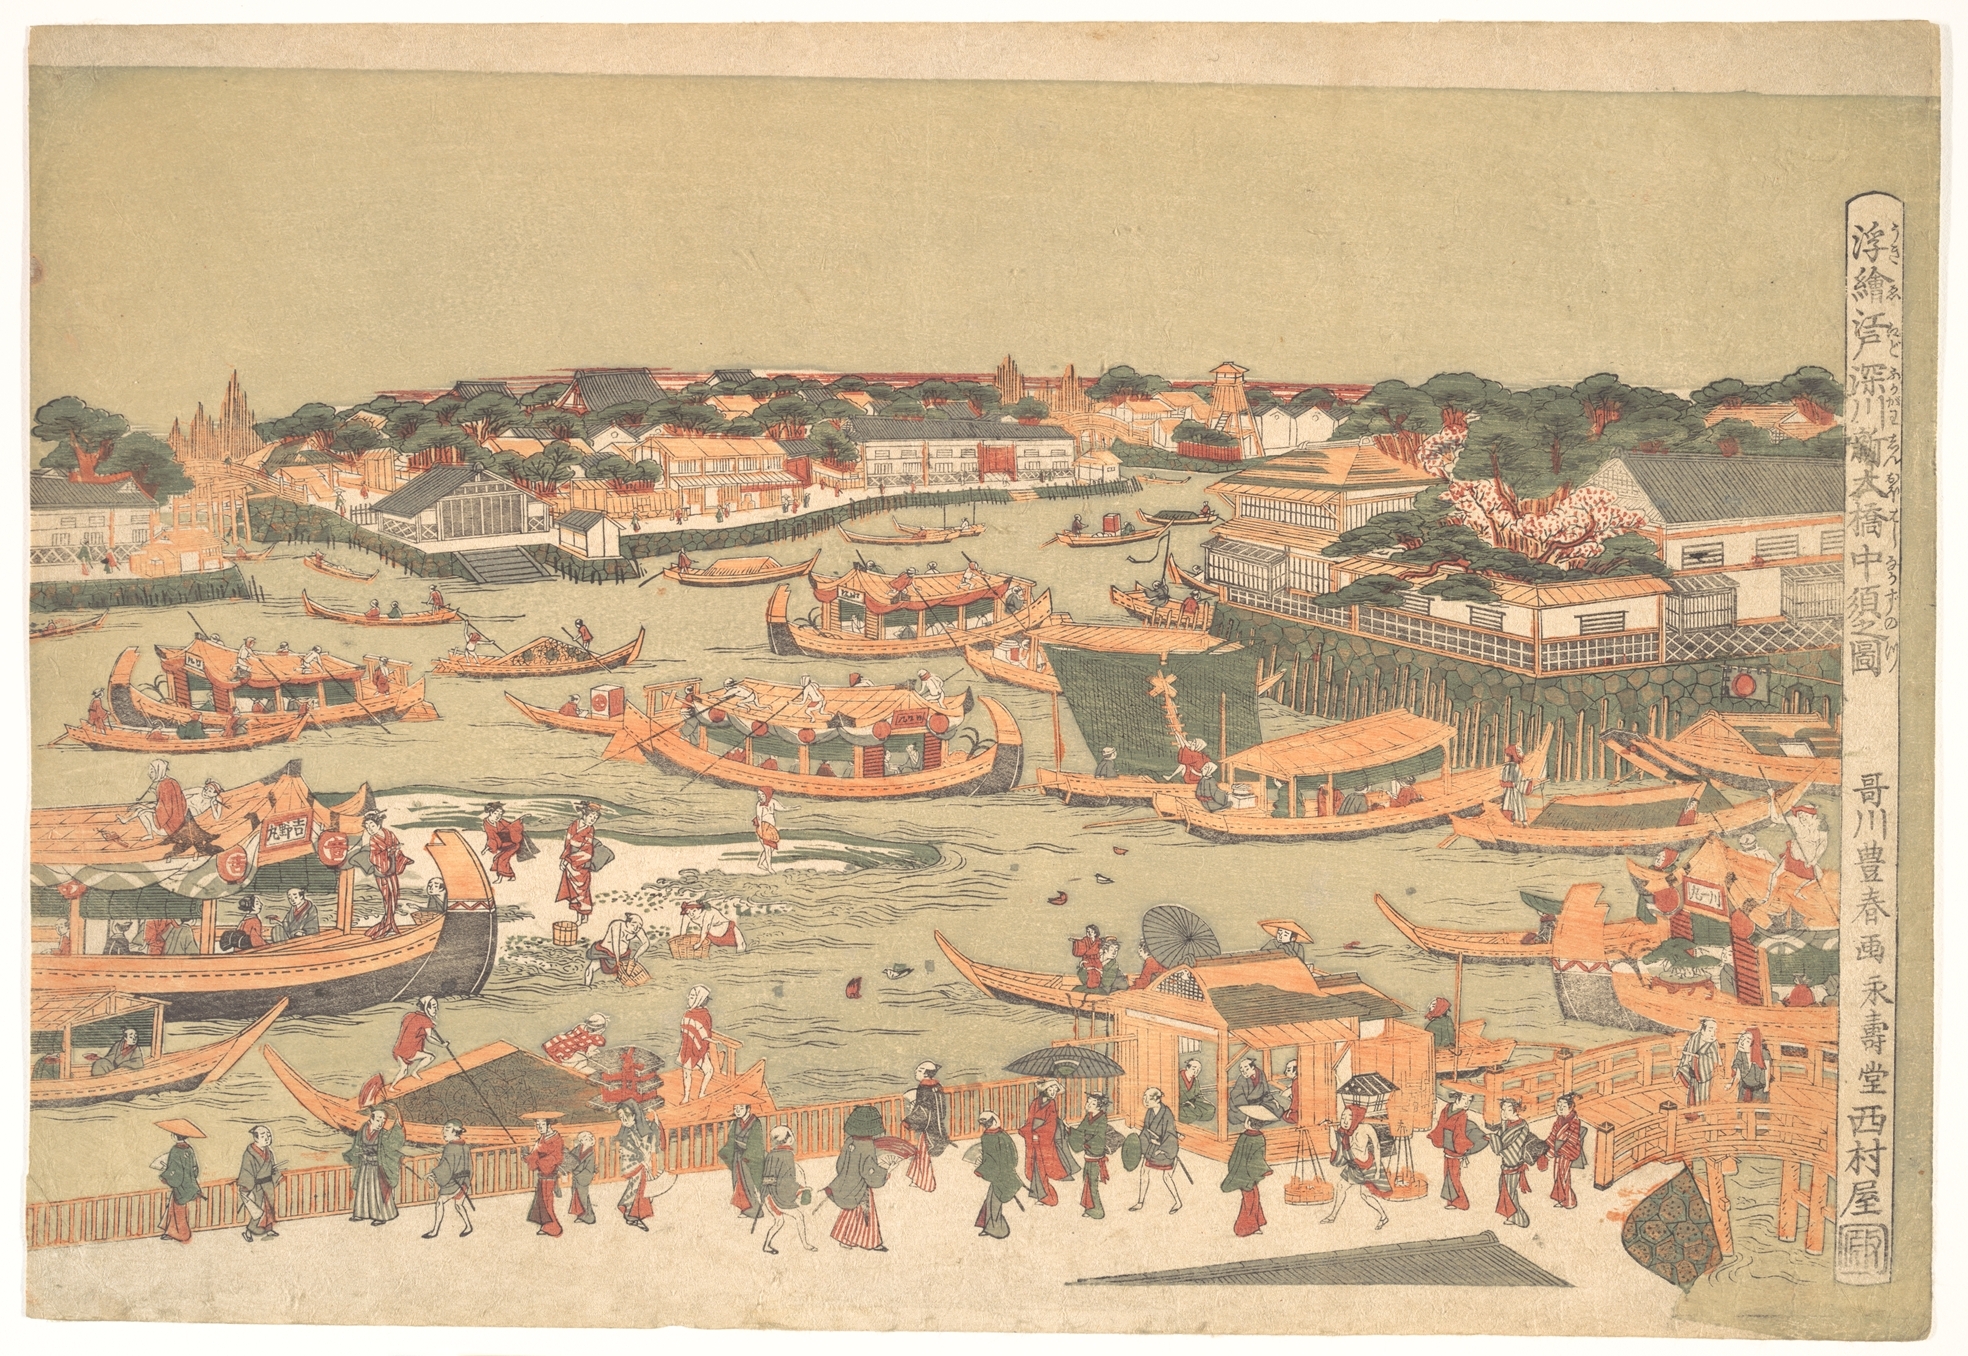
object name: print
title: New Great Bridge at Naka Zu in Edo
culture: japanese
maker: utagawa toyoharu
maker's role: artist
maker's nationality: japanese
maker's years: 1735-1814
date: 1780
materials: ink, paper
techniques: woodblock print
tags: bridges,crowd,boats